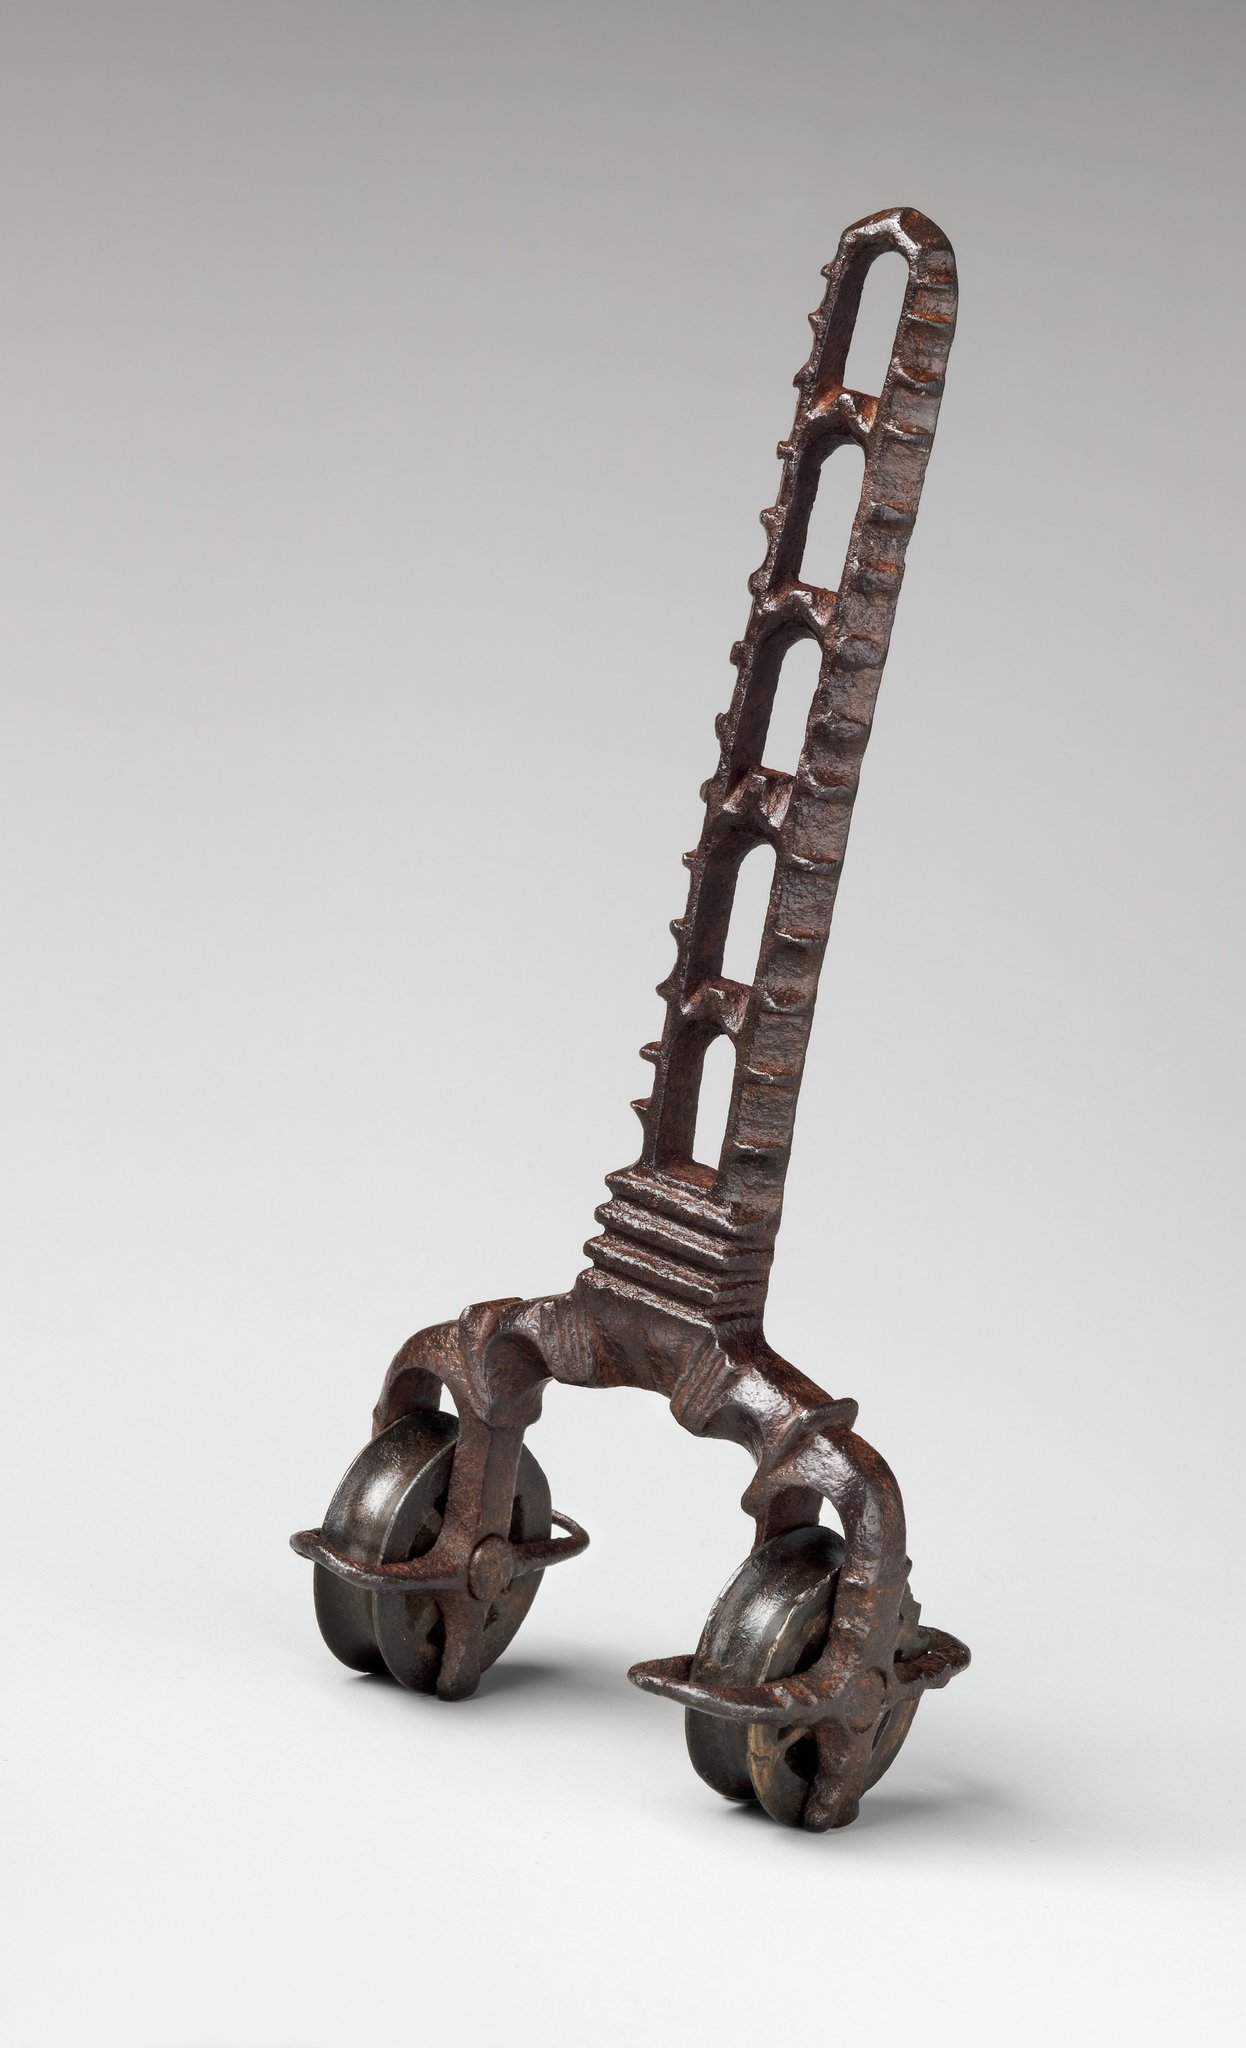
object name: anchor plate from a rope and pulley system to span a crossbow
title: Anchor Plate from a Rope-and-Pulley System to Span a Crossbow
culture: european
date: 1475-1525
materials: copper alloy, steel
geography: france